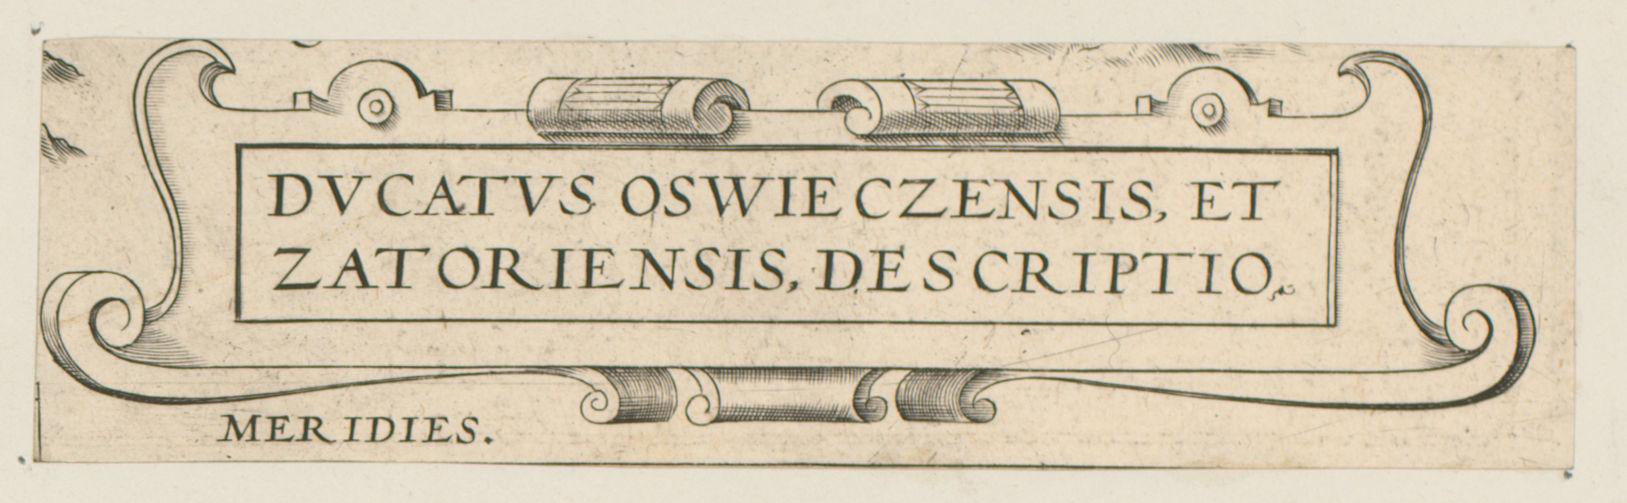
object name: print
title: Theatrum Orbis Terrarum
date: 1572-1575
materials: paper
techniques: engraving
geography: antwerp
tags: ornament ~ cartouche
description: Langwerpige cartouche met rolwerk. De cartouche is een fragment van een kaart van Pommern, Livonia en Auschwitz. De prent maakt deel uit van een album.